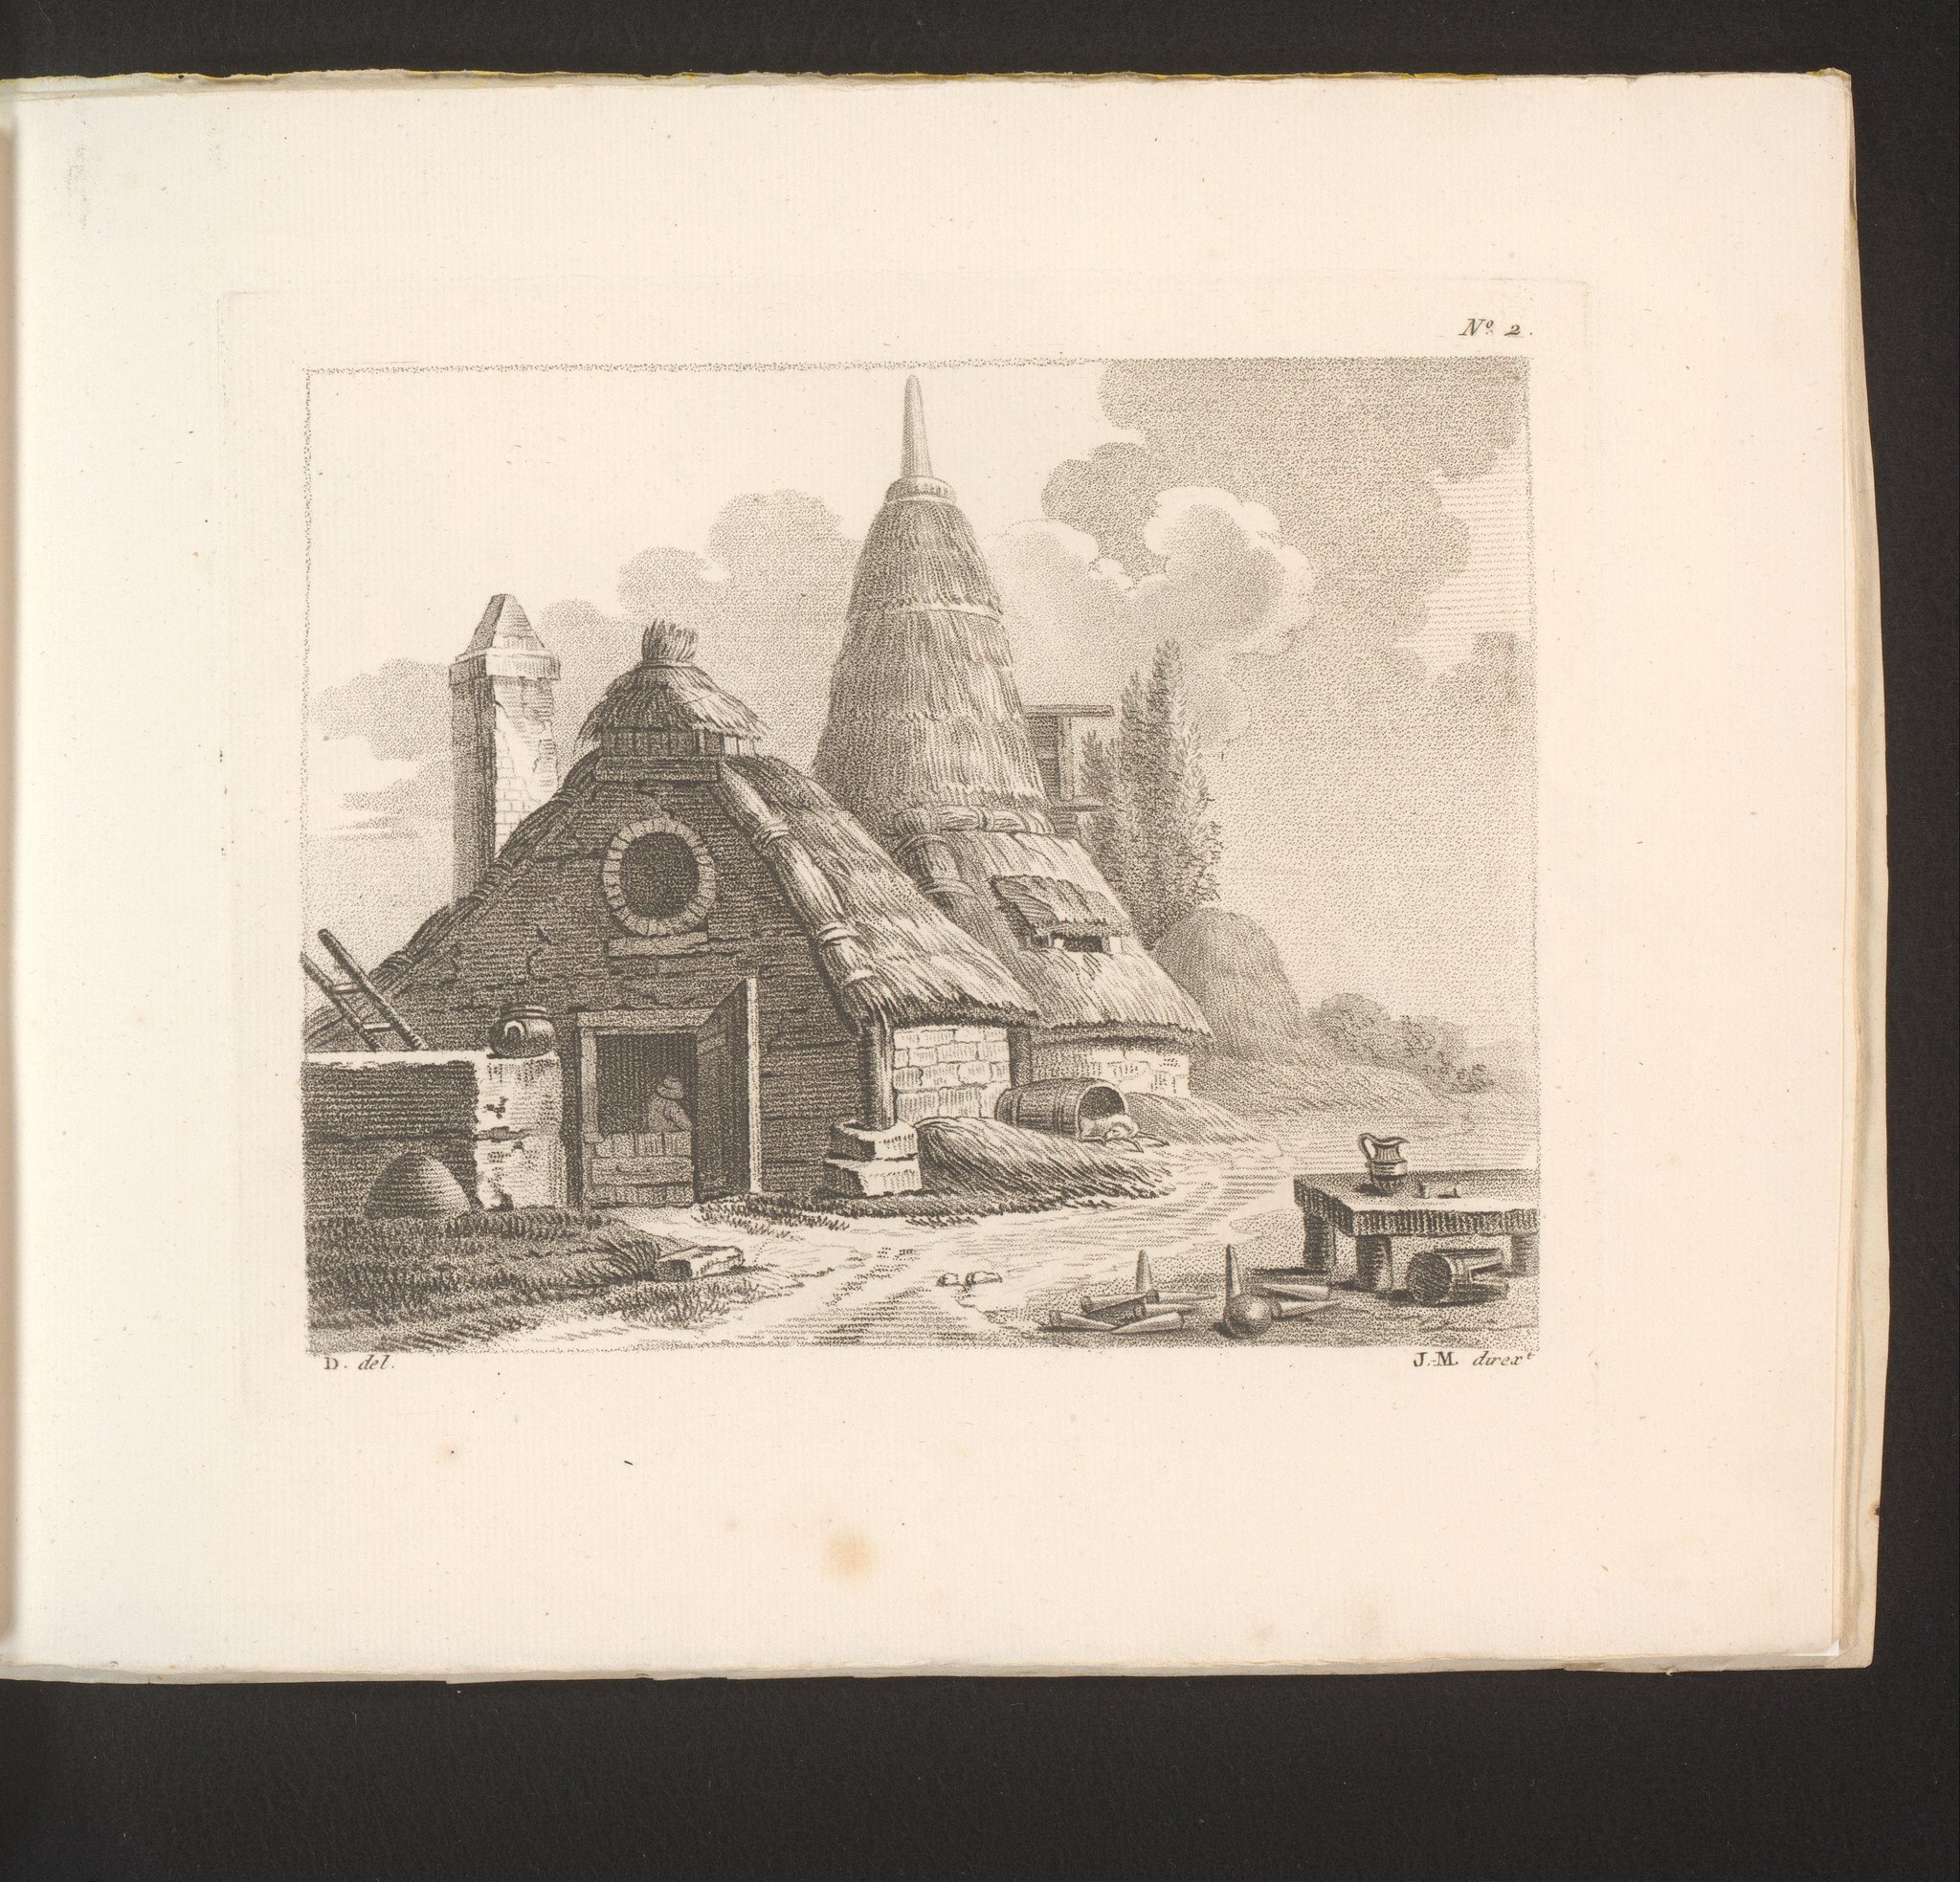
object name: album leaf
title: Kalkoven en schuur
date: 1800-1825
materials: paper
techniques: printmaking, engraving, etching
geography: paris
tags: barn, charcoal furnace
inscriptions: collector's mark: Lugt 2760, collector's mark: Lugt 2228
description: Deze prent maakt deel uit van een album.